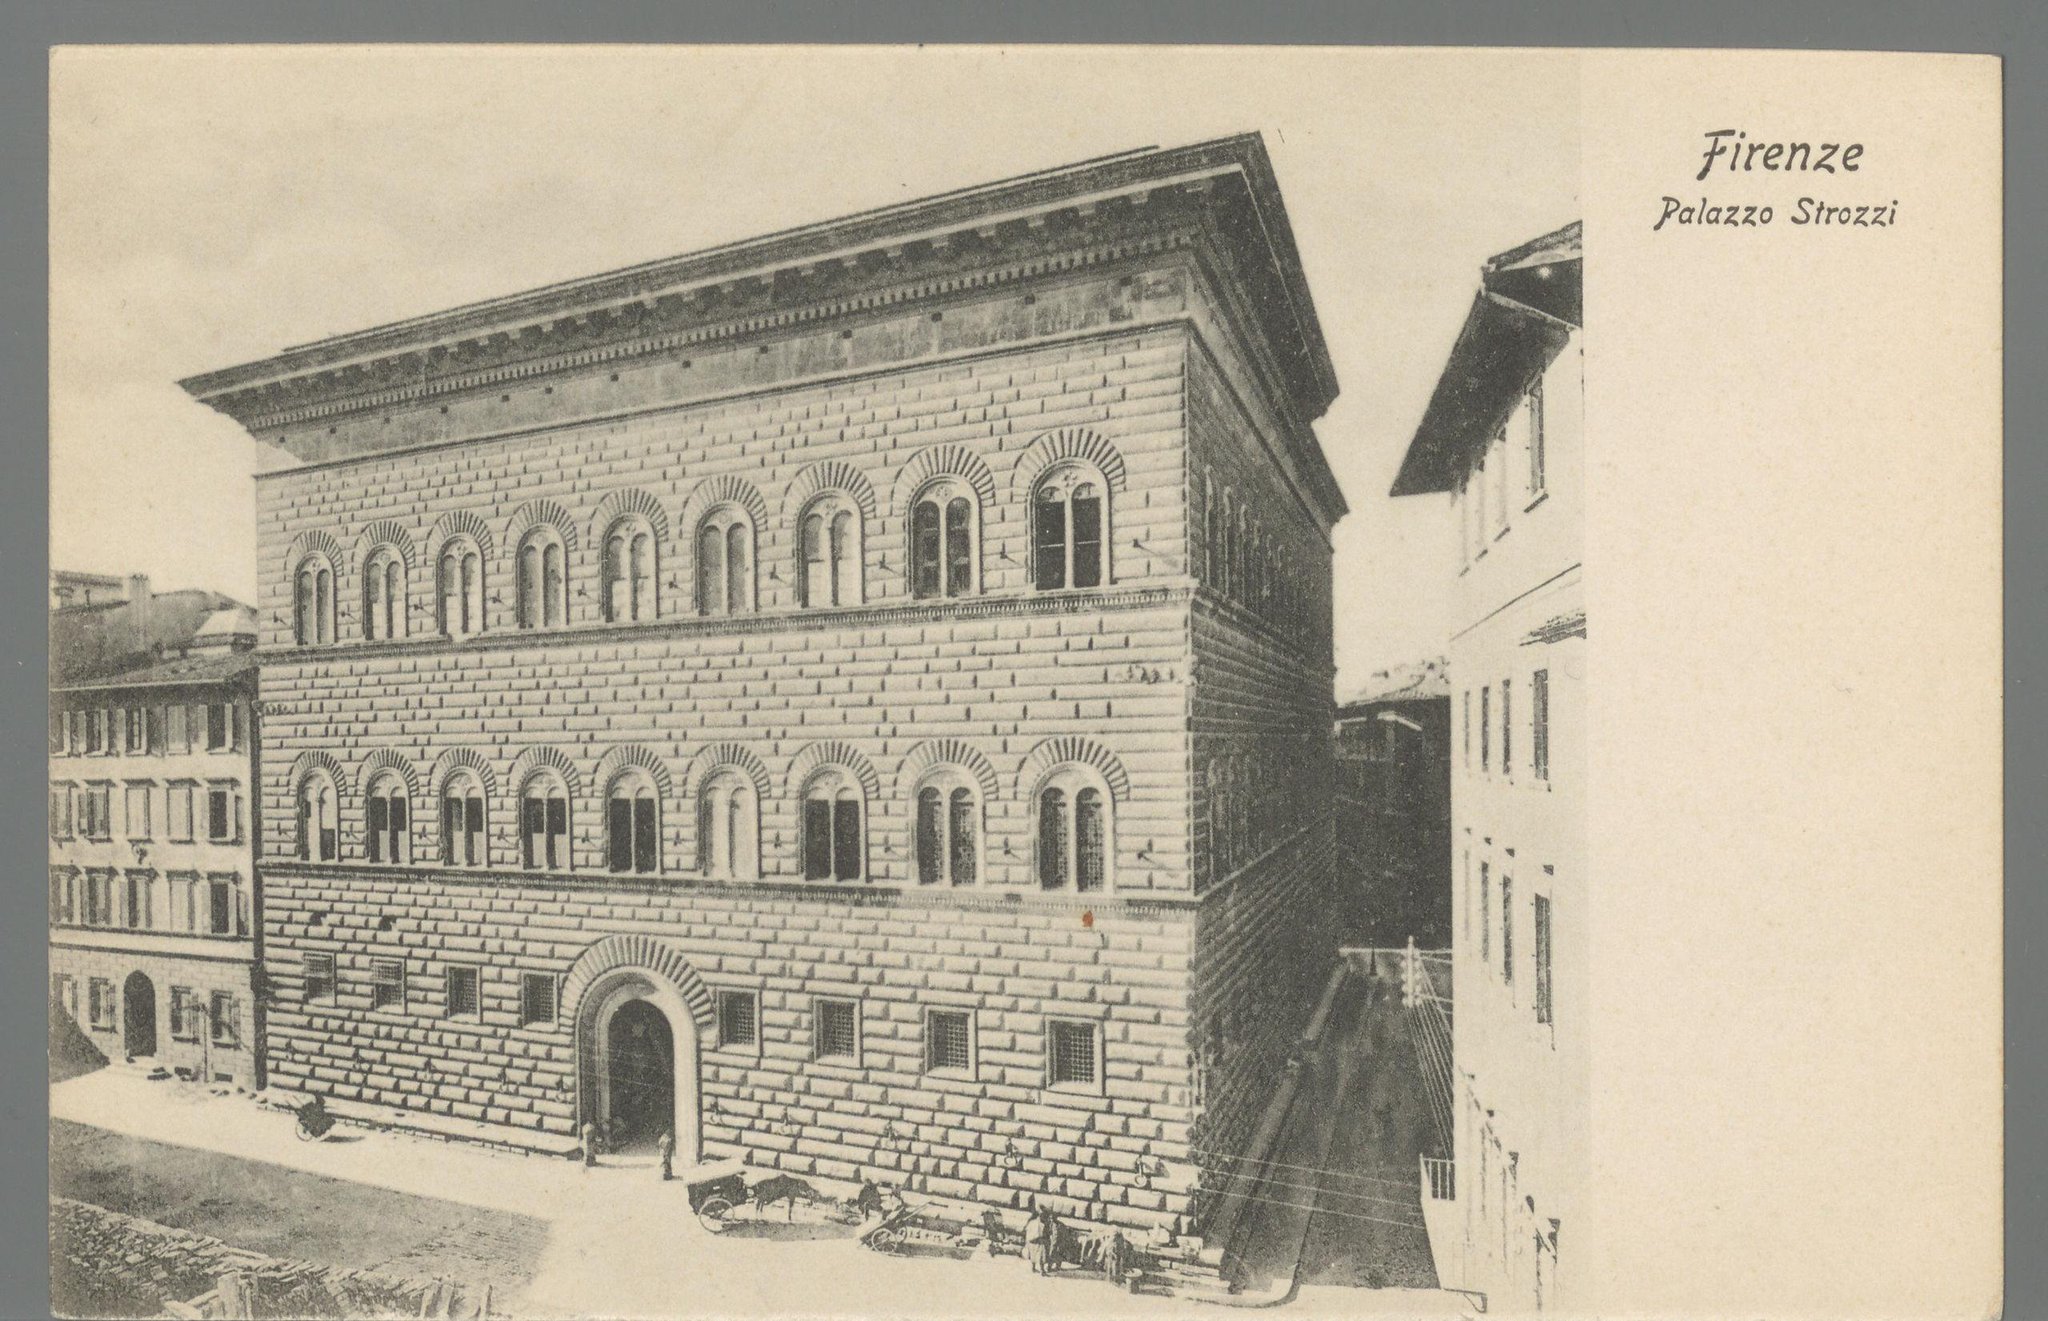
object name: photomechanical print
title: Firenze. Palazzo Strozzi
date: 1885-1905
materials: cardboard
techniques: photograph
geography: leipzig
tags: palace, city-view, and landscape with man-made constructions (+ city(-scape) with figures, staffage)